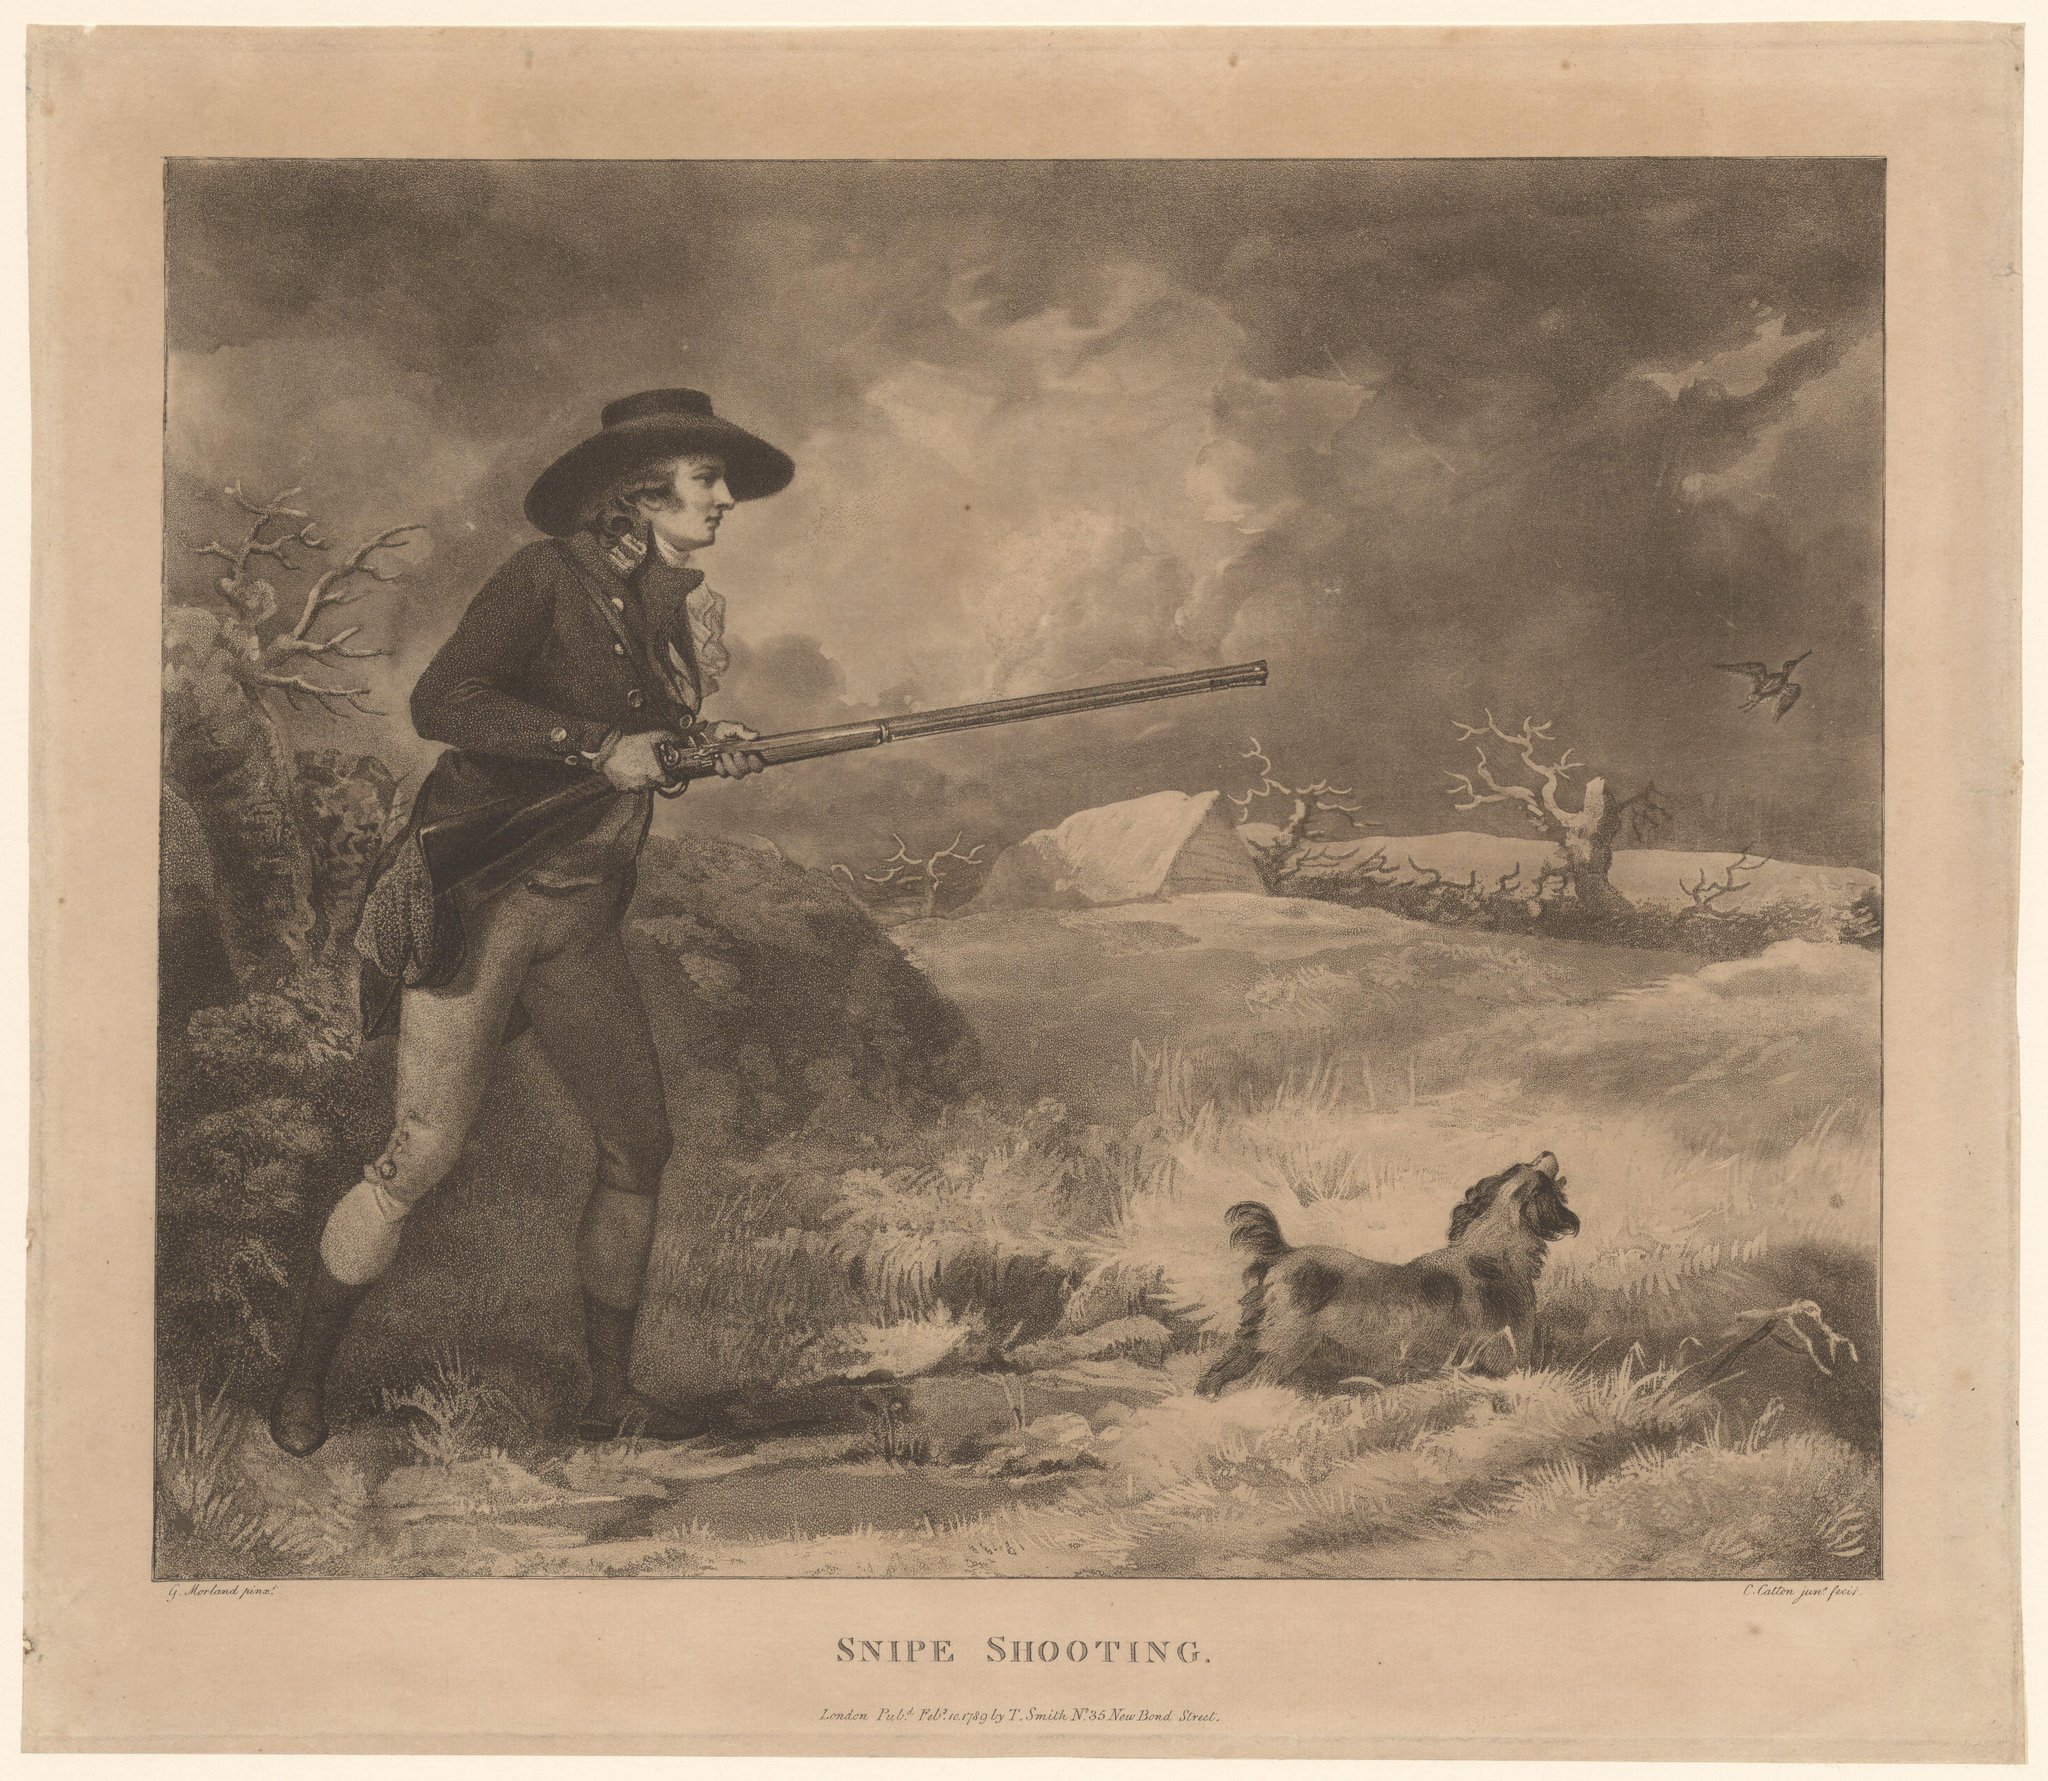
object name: print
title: Snipe Shooting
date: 1789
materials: paper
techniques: aquatint, etching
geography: london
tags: hunting dogs, bird hunting, shore-birds and wading-birds: woodcock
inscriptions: collector's mark: Lugt 2228